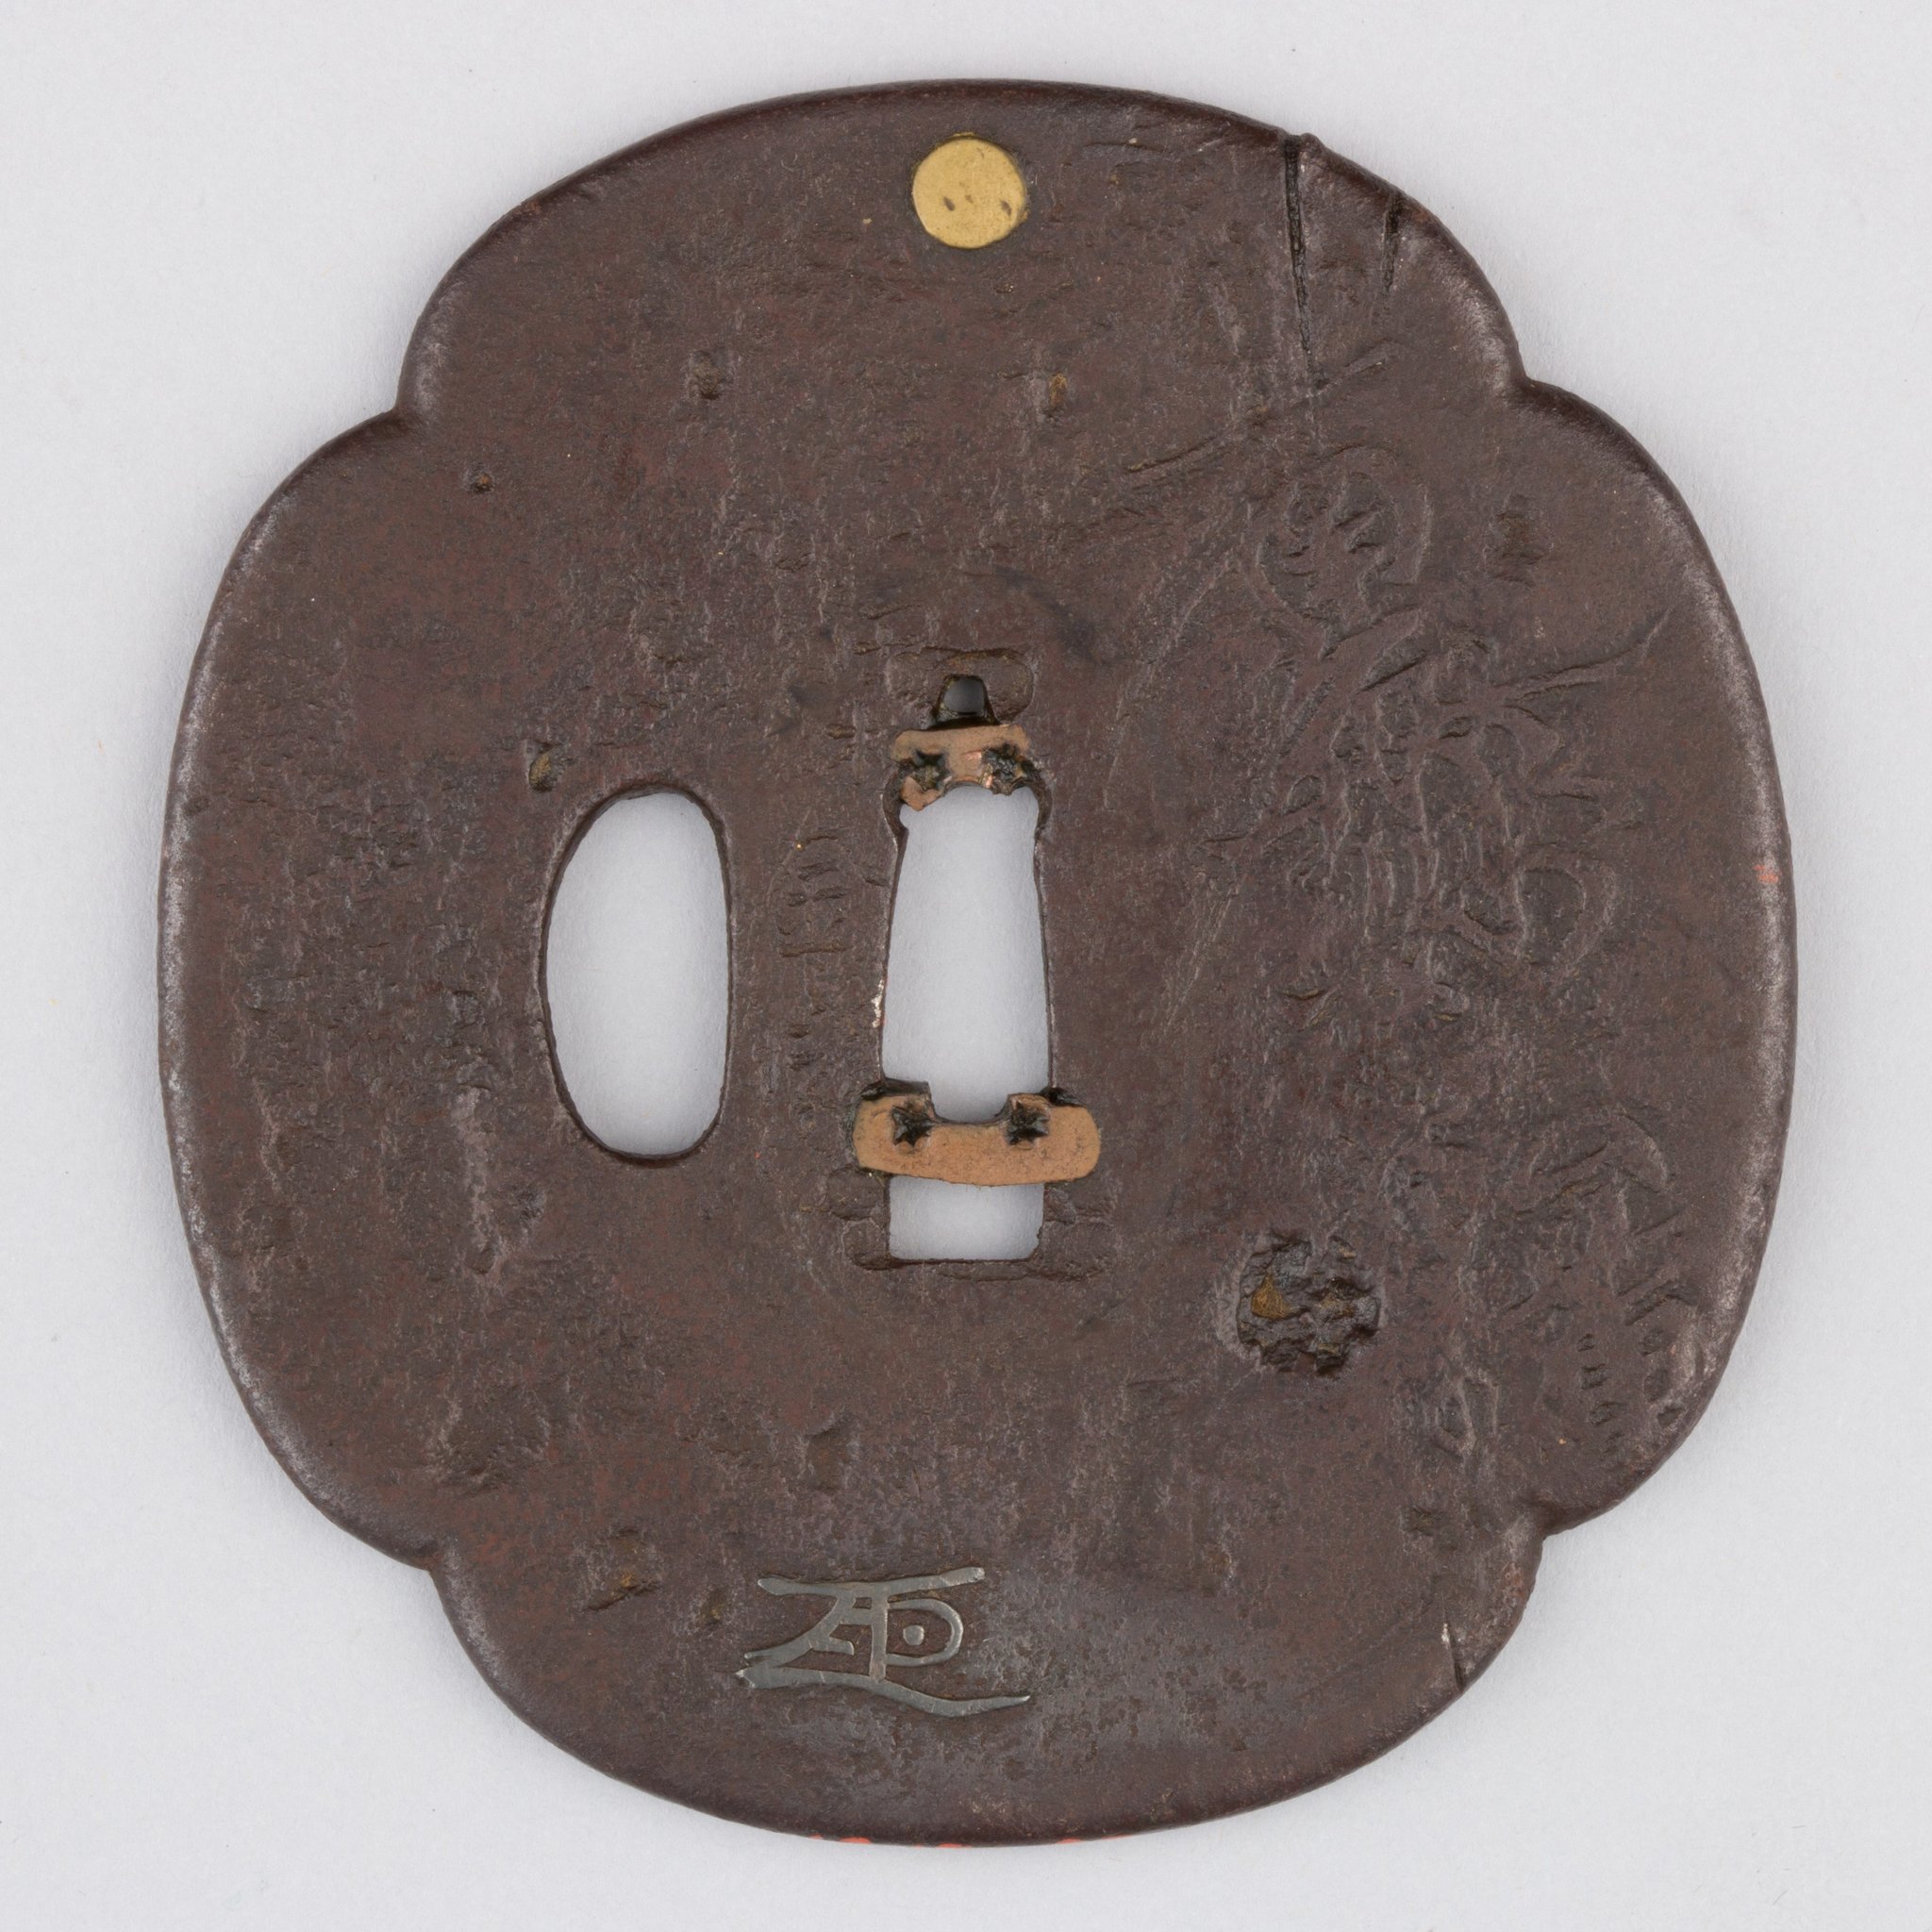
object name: sword guard tsuba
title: Sword Guard (Tsuba)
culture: japanese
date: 1615-1868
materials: copper, iron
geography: japan